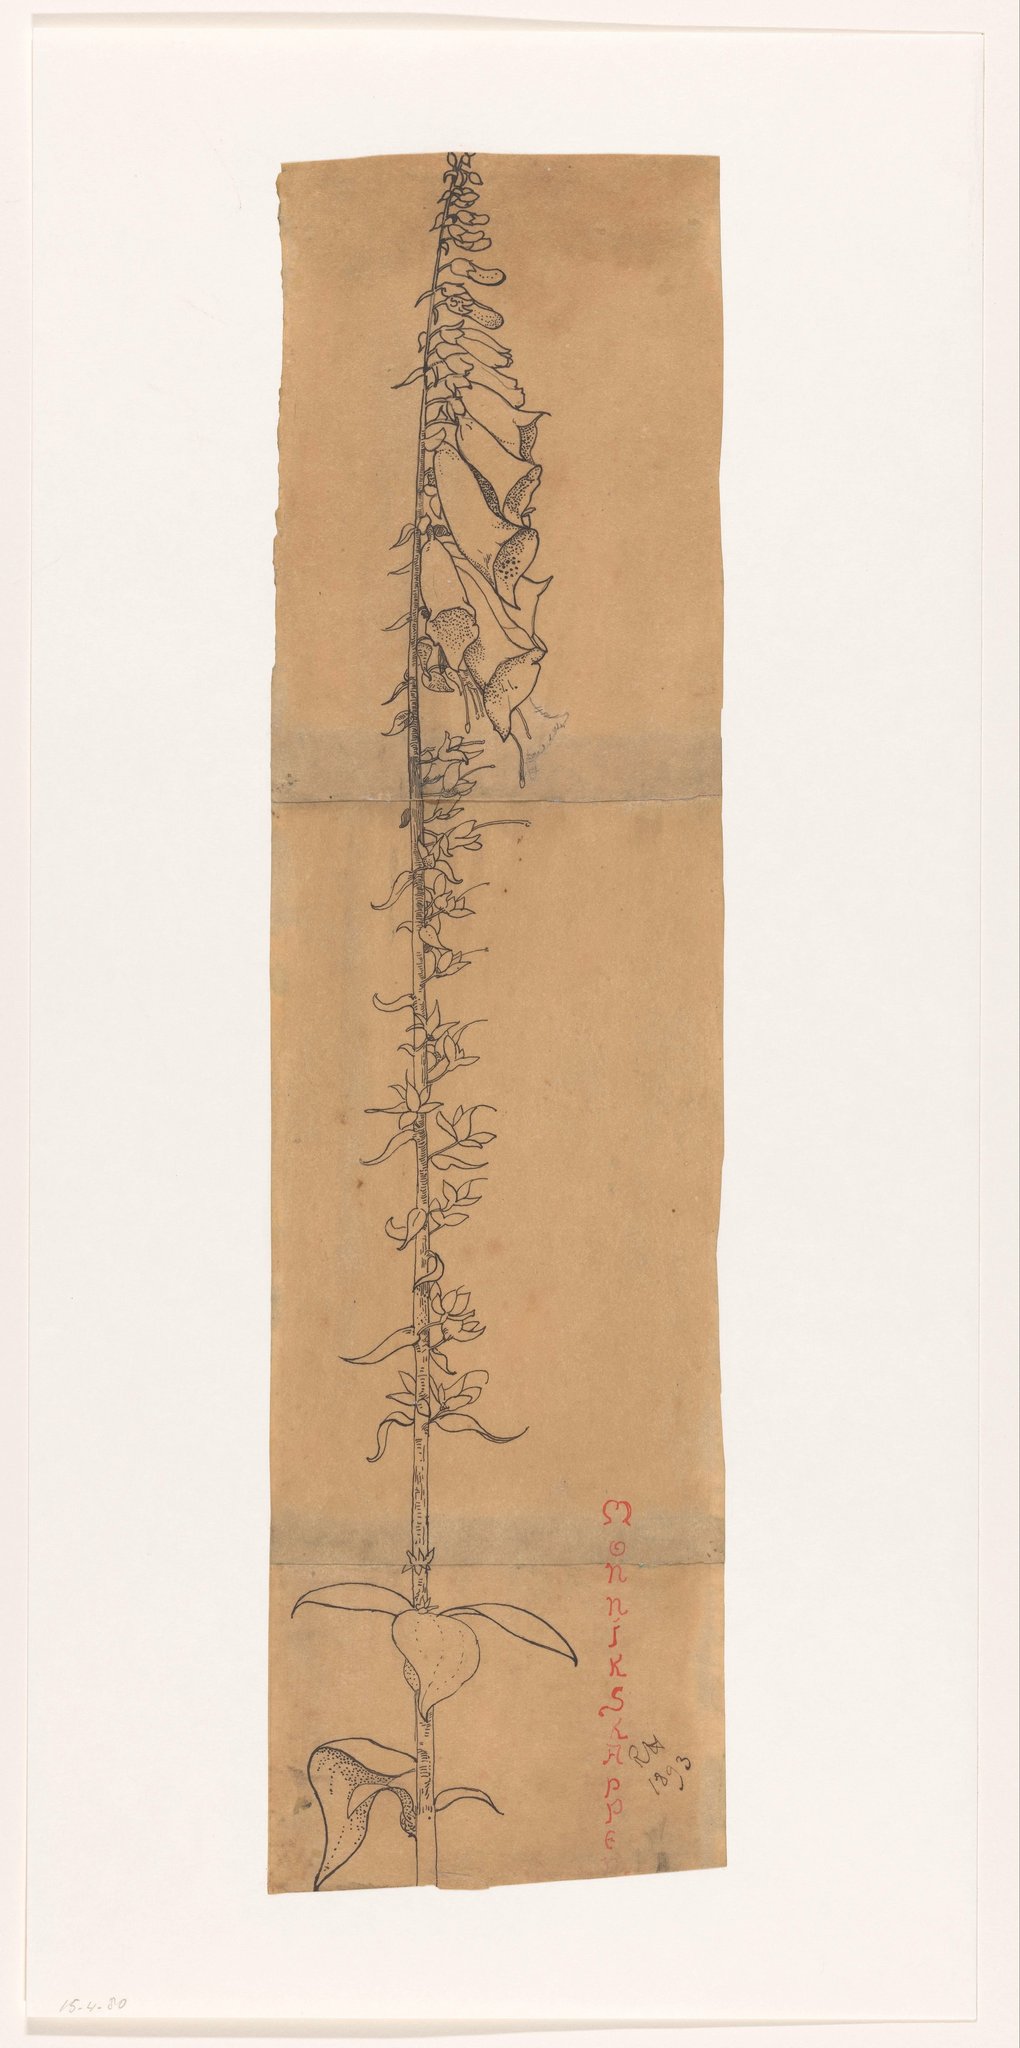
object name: drawing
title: Vingerhoedskruid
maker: richard nicolaüs roland holst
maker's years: 1868-1938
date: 1893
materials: ink, paper, pencil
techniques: pen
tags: flowers: foxglove